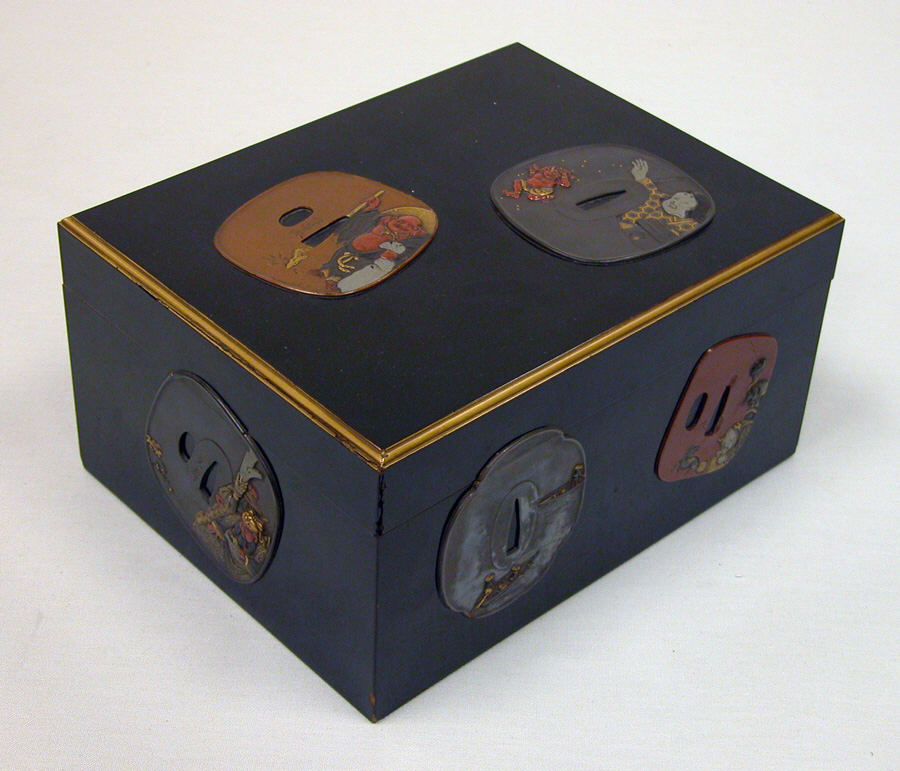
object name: covered box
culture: japanese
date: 1868-1912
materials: lacquer